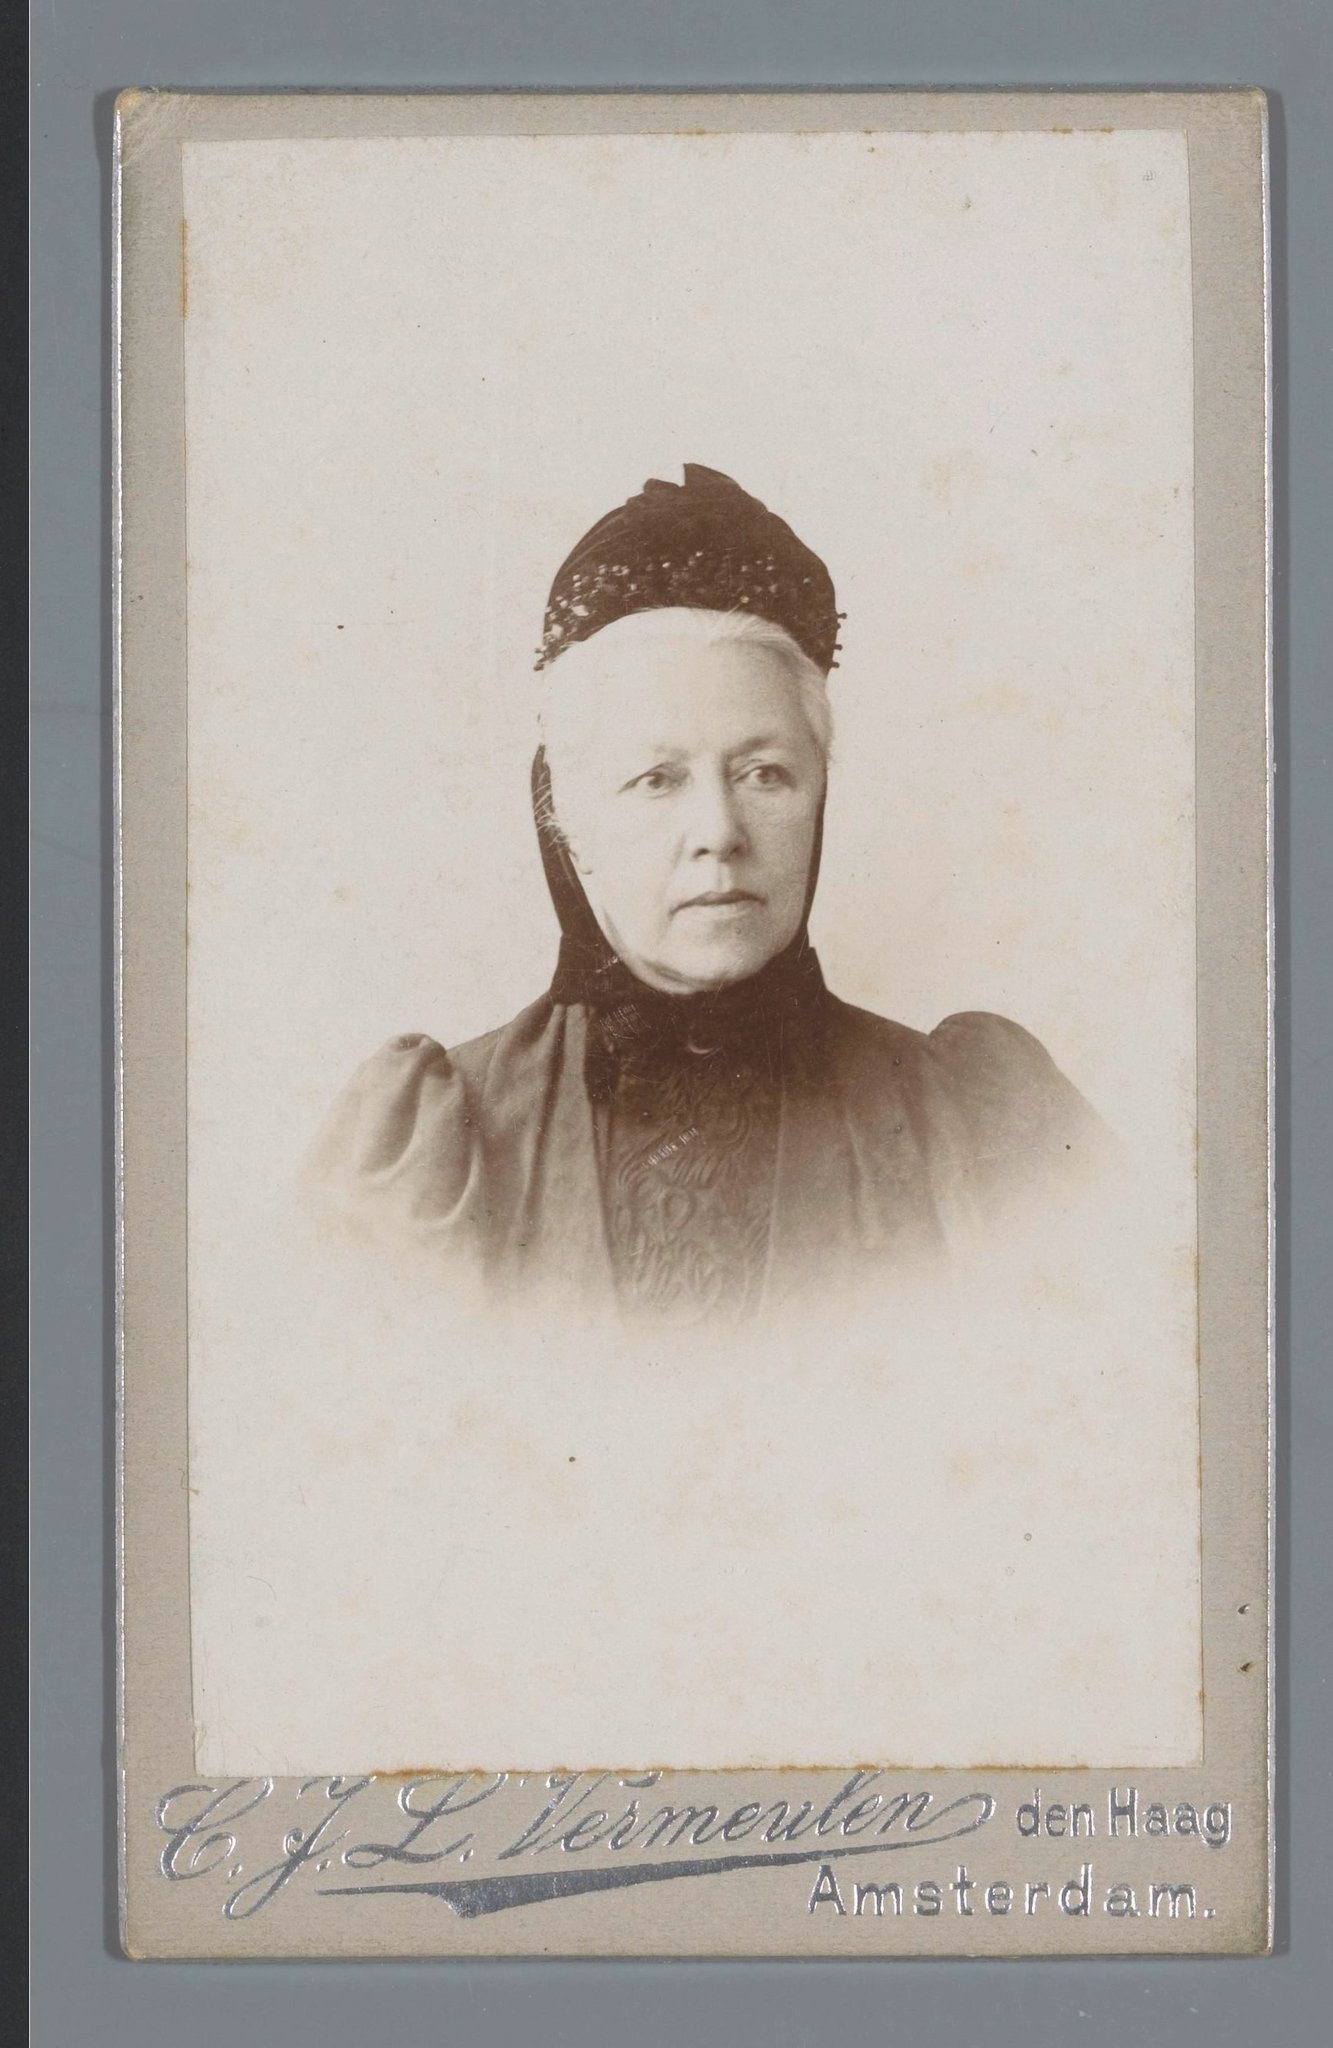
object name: carte de visite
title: Portret van een onbekende vrouw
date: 1890-1915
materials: cardboard, photographic support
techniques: collodion silver print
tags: historical persons - bb - woman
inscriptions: inscription: ‘C. J. L. Vermeulen/ Heiligenweg hoek Singel/ Heerenstraat 6./ Telephoon No. 2339 en 2340./ Amsterdam./ Toussaintkade 11./ den Haag./ Intercommunal Telephon: 774.’